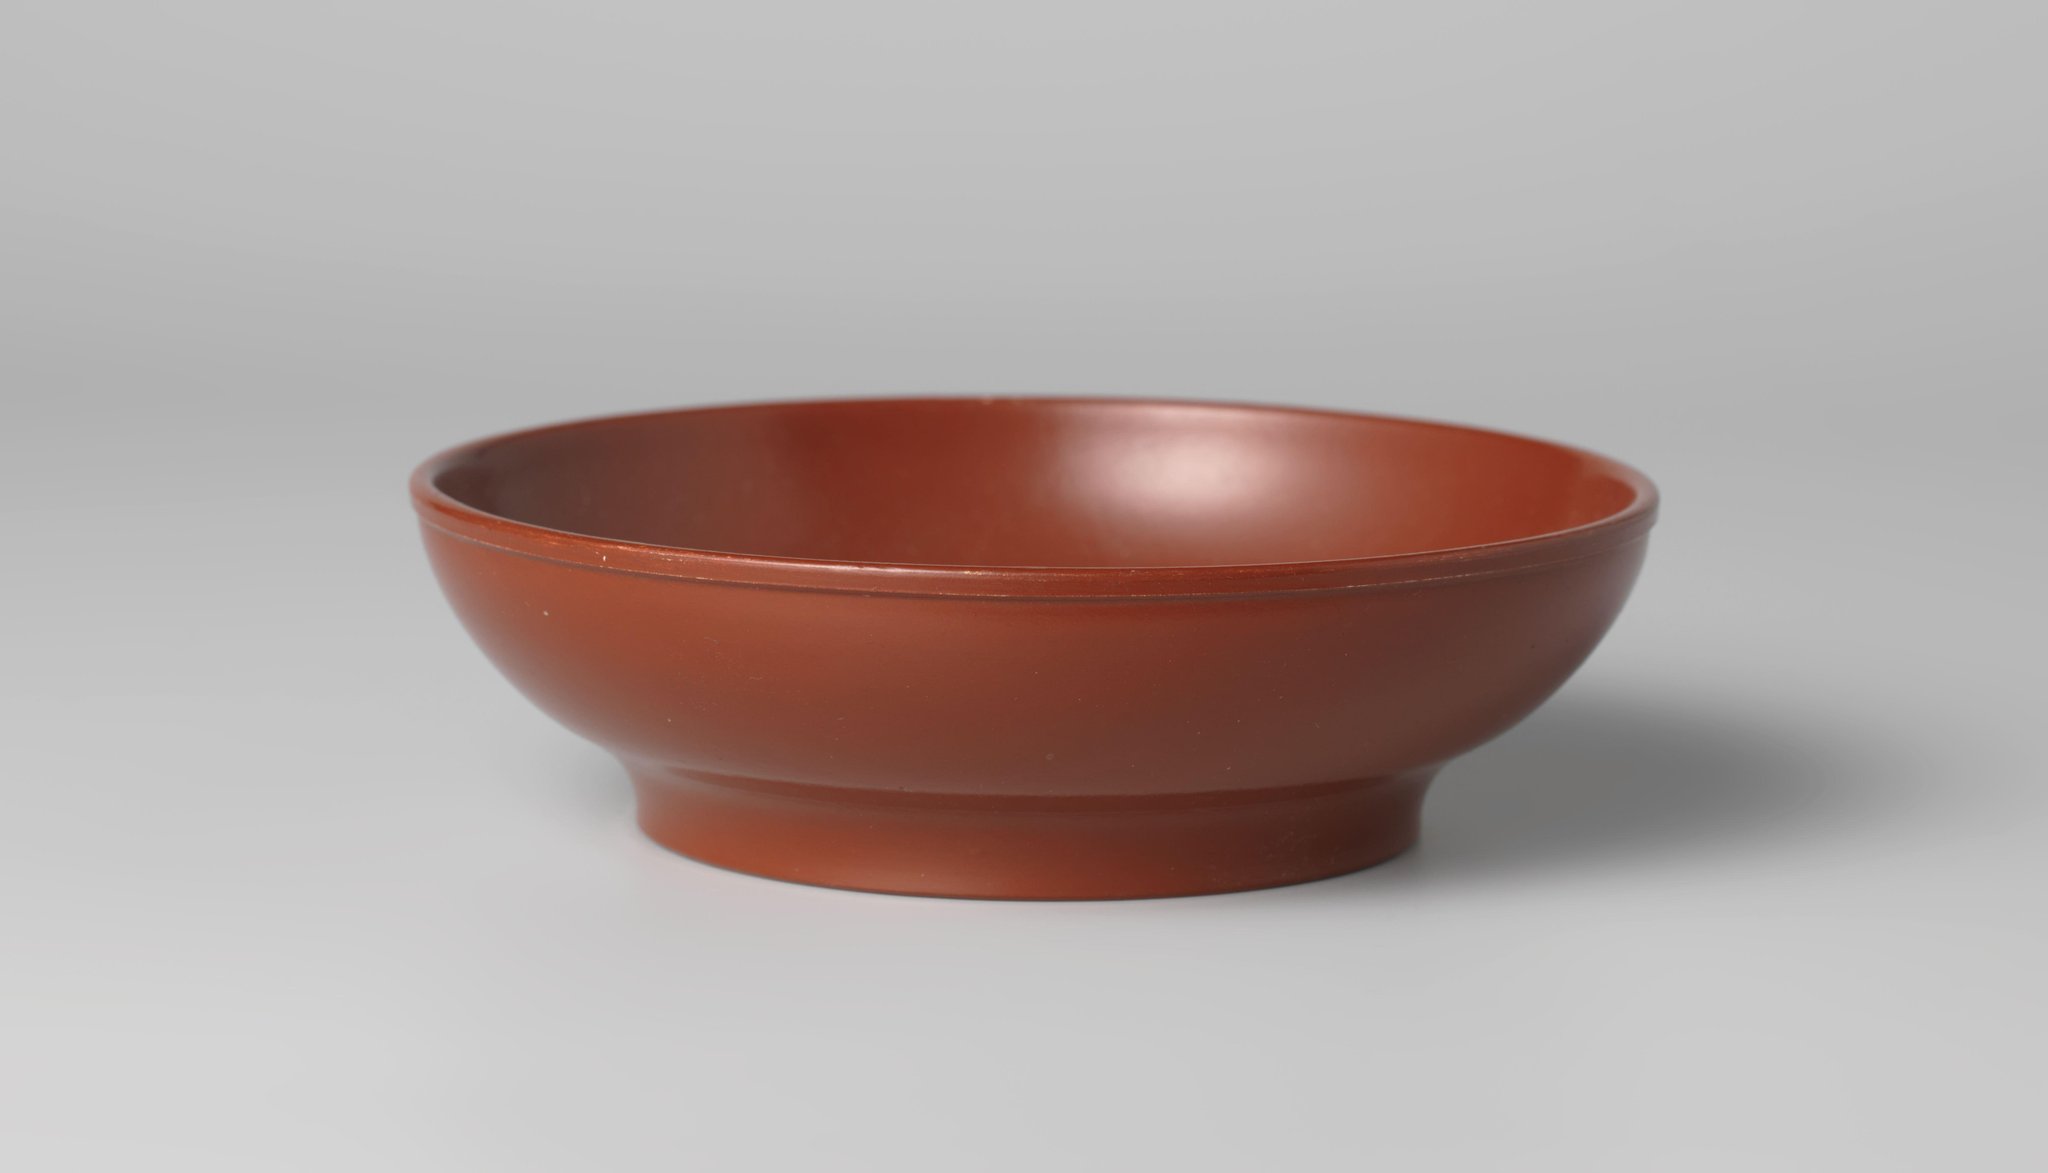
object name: slop bowl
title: Spoelkom van rood hardgebakken aardewerk, kinderspeelgoed.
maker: Anonymous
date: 1830-1860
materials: earthenware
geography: bohemia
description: Halfbolvormige spoelkom van rood hardgebakken aardewerk. De kom heeft een standring. De kom is in reliëf versierd met guirlandes met guirlandes van bladeren en vruchten. De spoelkom hoort bij een miniatuur theeservies (BK-15429-A t/m BK-15429-D).